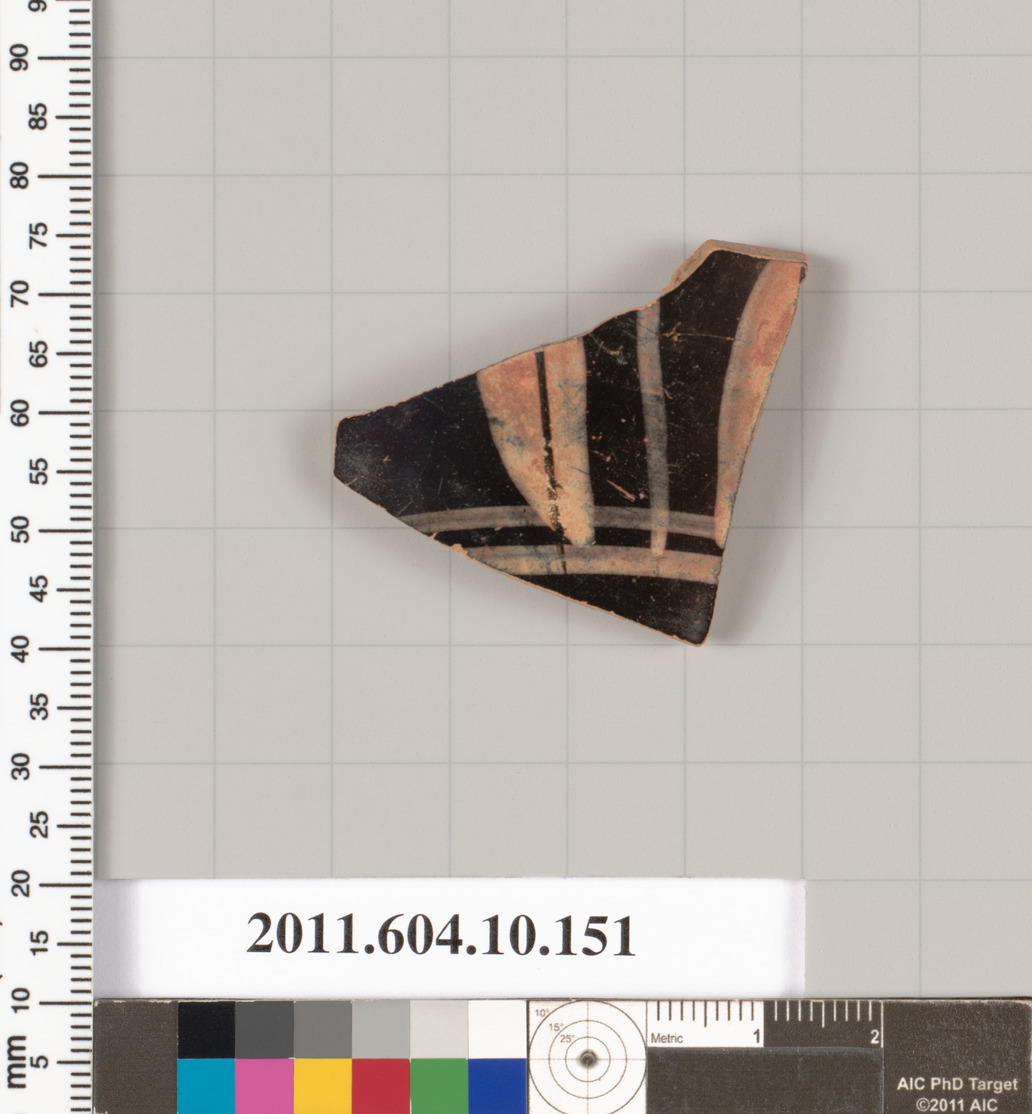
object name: skyphos fragment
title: Terracotta fragment of a skyphos (deep drinking cup)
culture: etruscan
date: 434-401 BCE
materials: terracotta